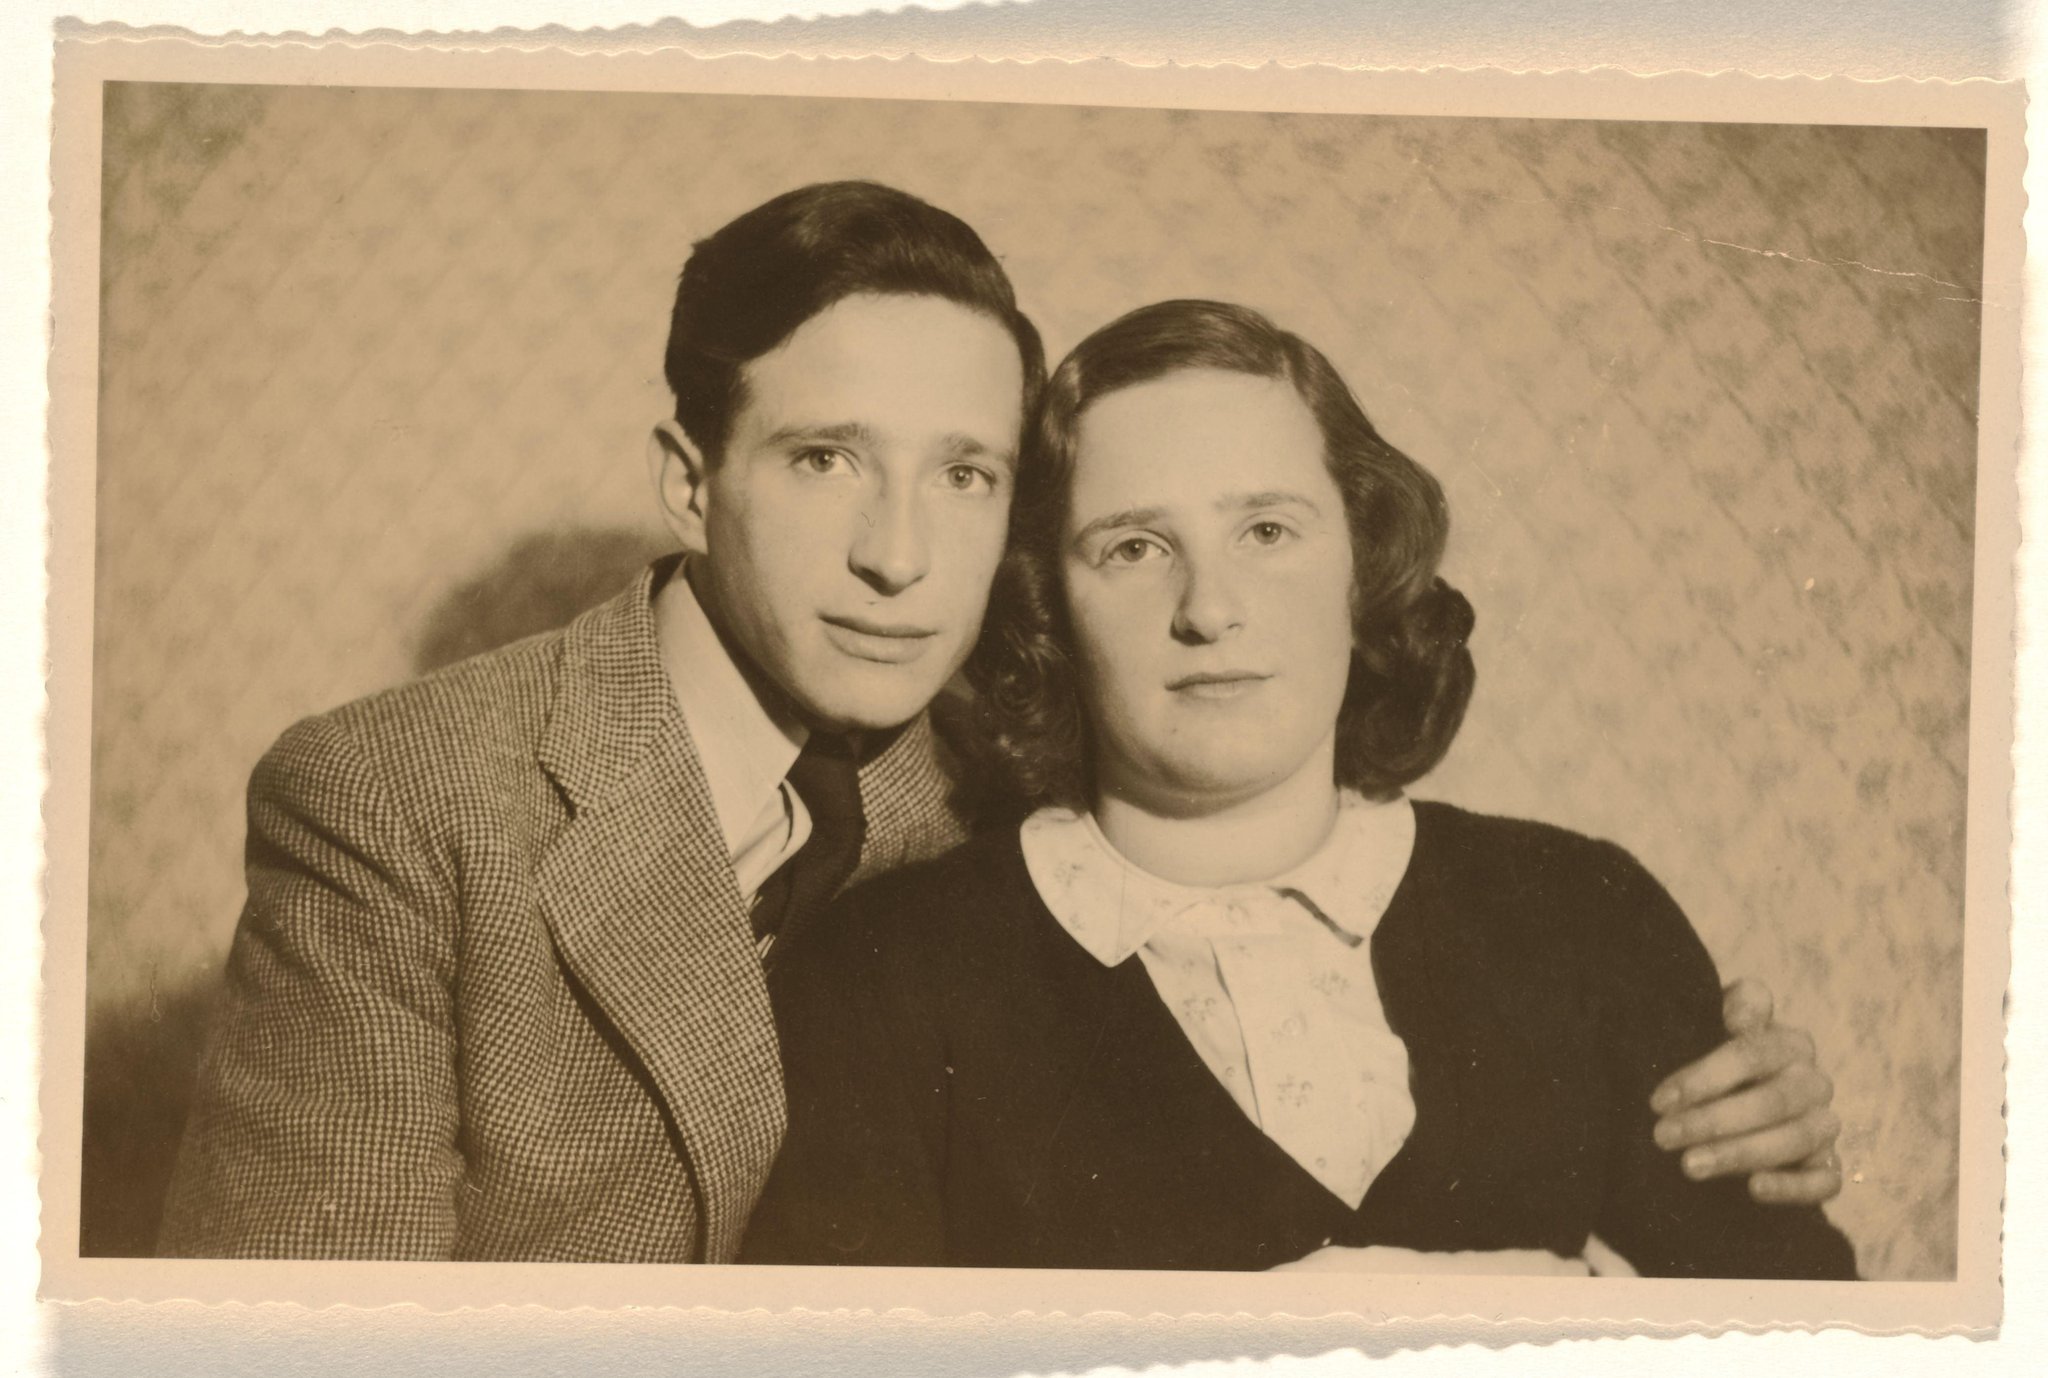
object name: photograph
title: Leo Blumensohn in gestreept colbert met zijn arm om Isabel Wachenheimer heen geslagen, voor een ruitvorming benah, beiden met serieuze blik, 1945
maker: Anonymous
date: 1945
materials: photographic support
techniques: gelatin silver print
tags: isabel wachenheimer-elon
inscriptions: inscription: ‘1945 stärke 5054’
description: Leo Blumensohn in gestreept colbert met zijn arm om Isabel Wachenheimer heen geslagen, voor een ruitvorming benah, beiden met serieuze blik, 1945